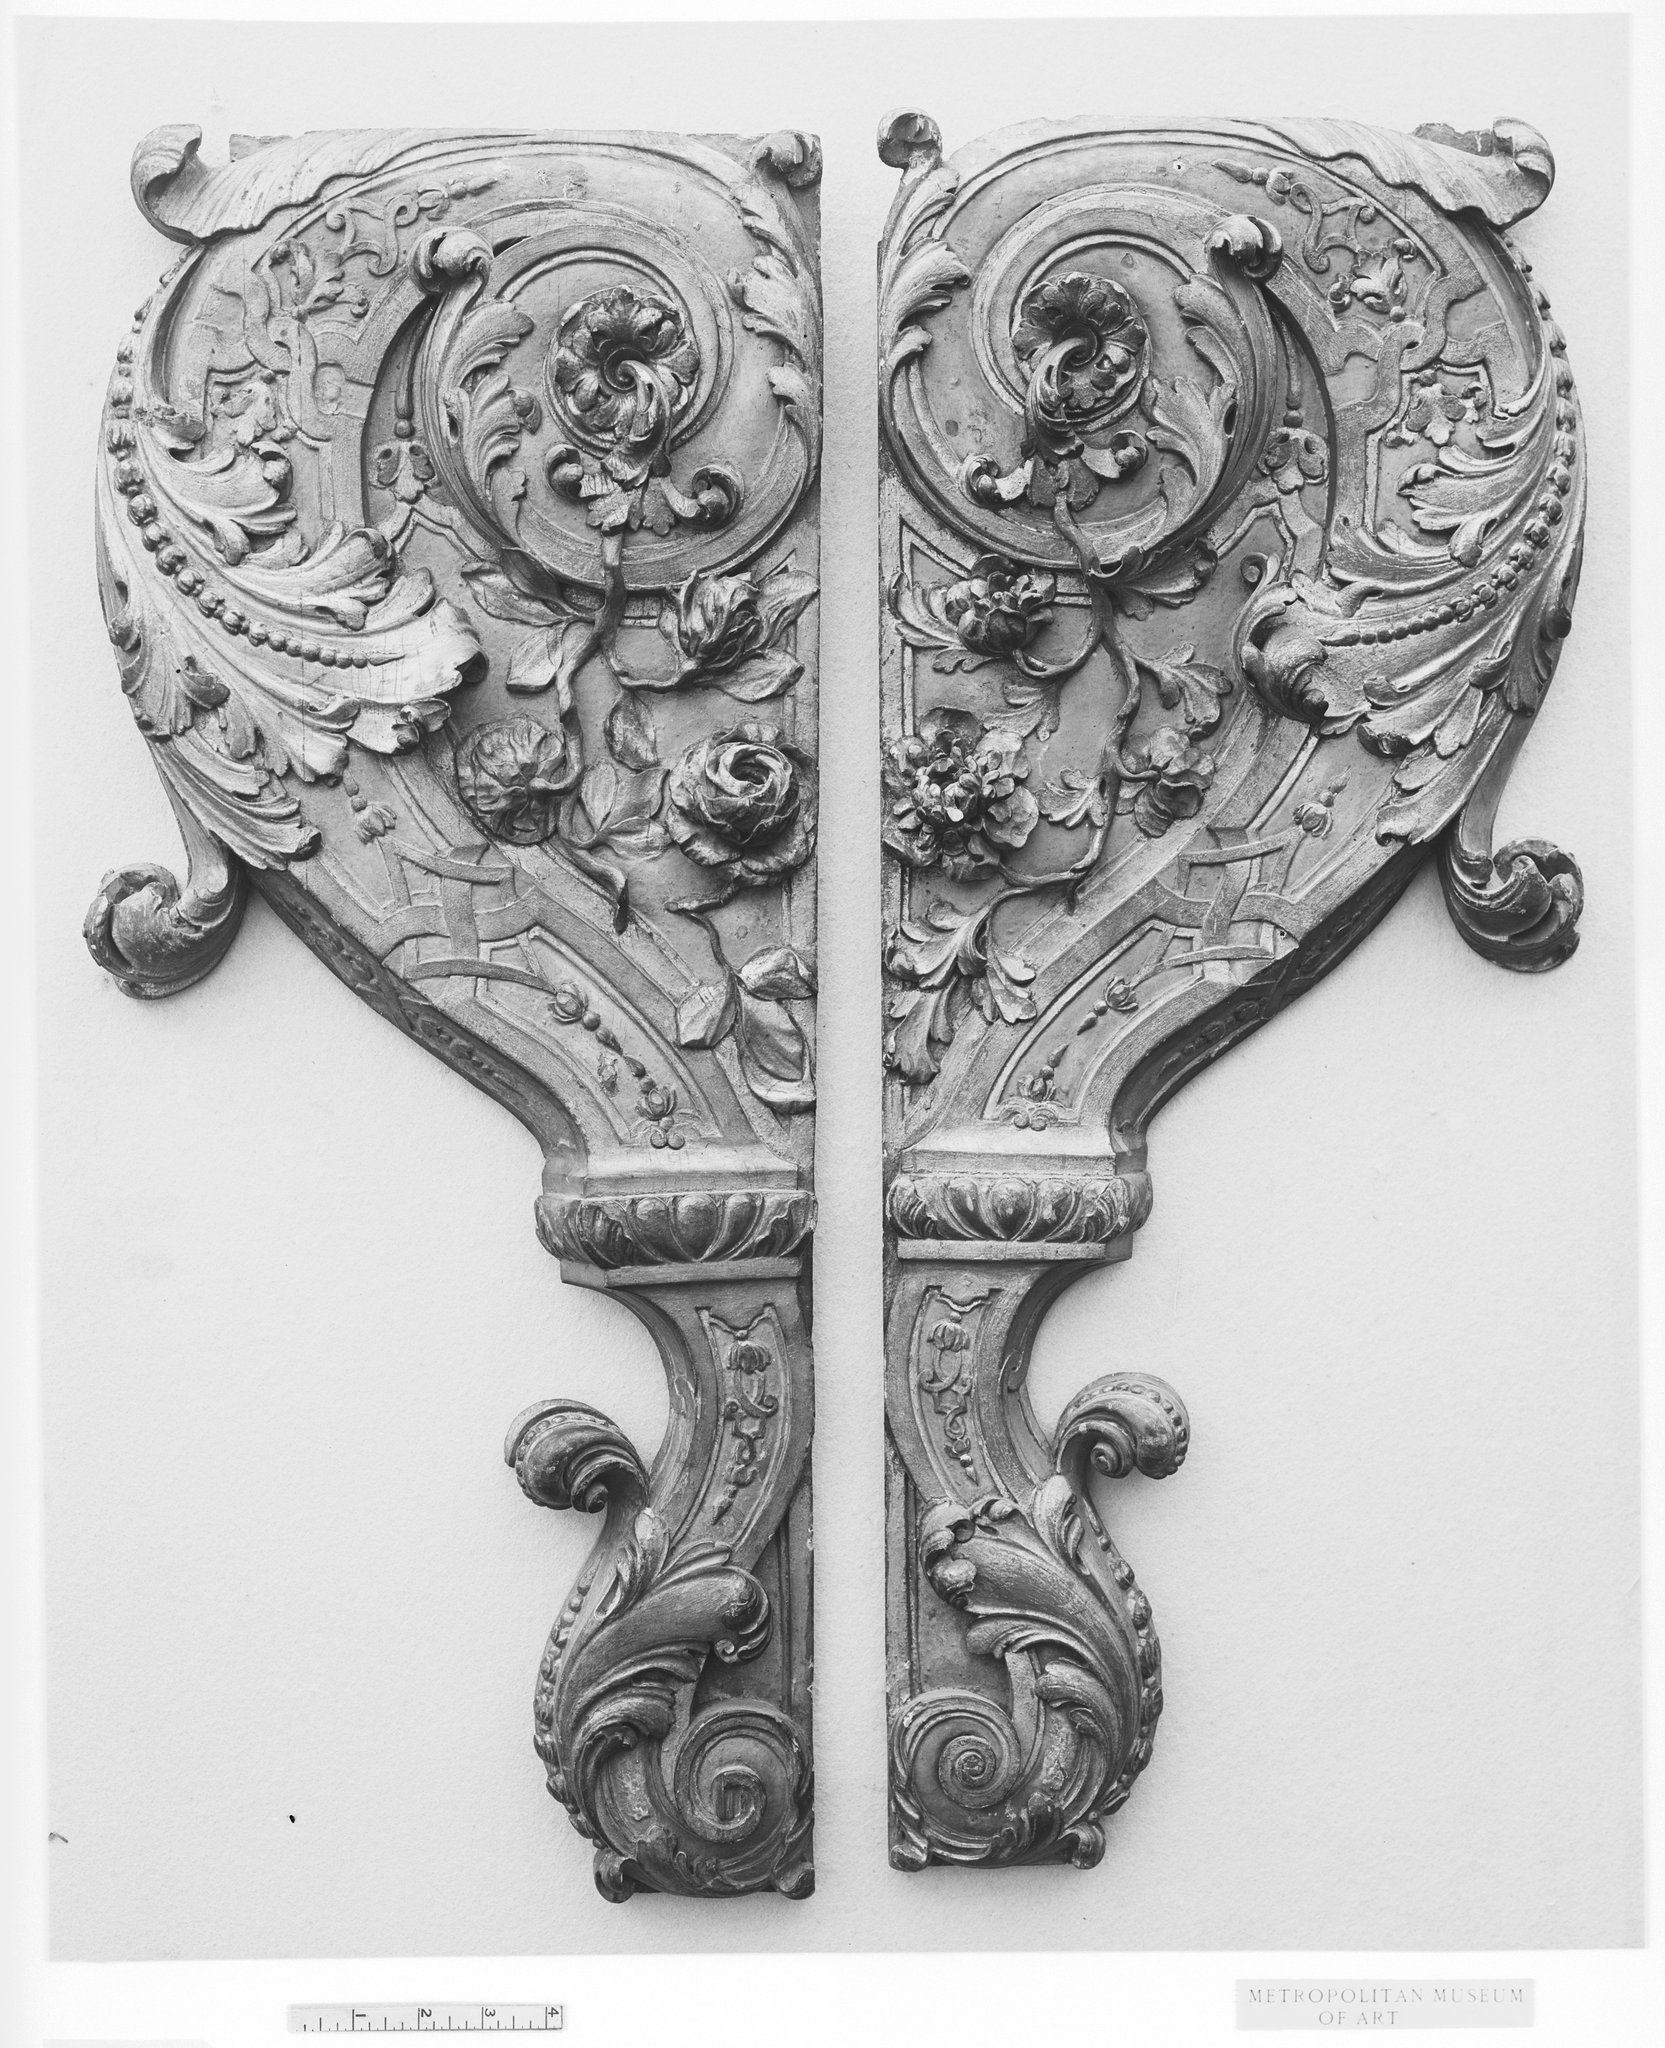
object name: console support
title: Pair of console supports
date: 1701-1733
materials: wood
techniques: carving, painting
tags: flowers,leaves